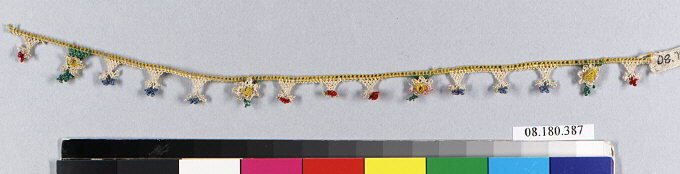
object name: fragment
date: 1801-1900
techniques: lace